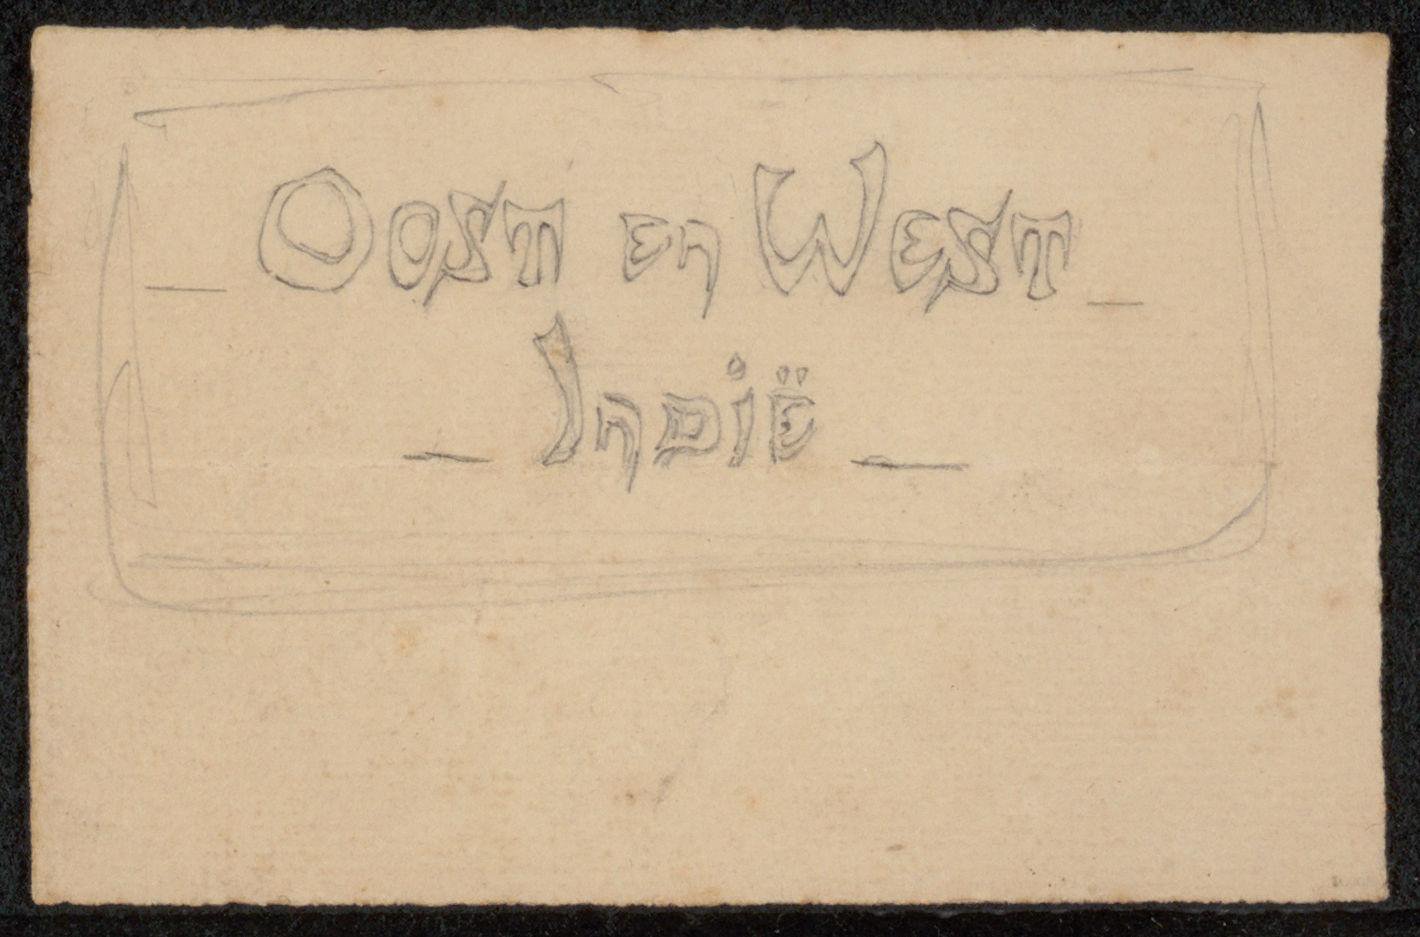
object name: design drawing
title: Ontwerptekening uit archief Philip Zilcken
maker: cornelia van der hart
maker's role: print maker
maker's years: 1851-1940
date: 1861-1940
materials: paper, pencil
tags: the hague, painter, draughtsman, philip zilcken, letters, alphabet, script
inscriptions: collector's mark: ‘RPK’